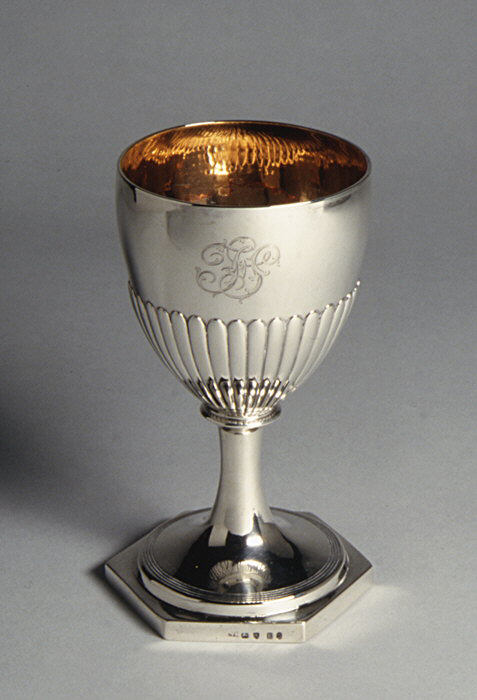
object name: standing cup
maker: naphtäli hart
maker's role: maker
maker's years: 1734-1834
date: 1800-1801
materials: silver